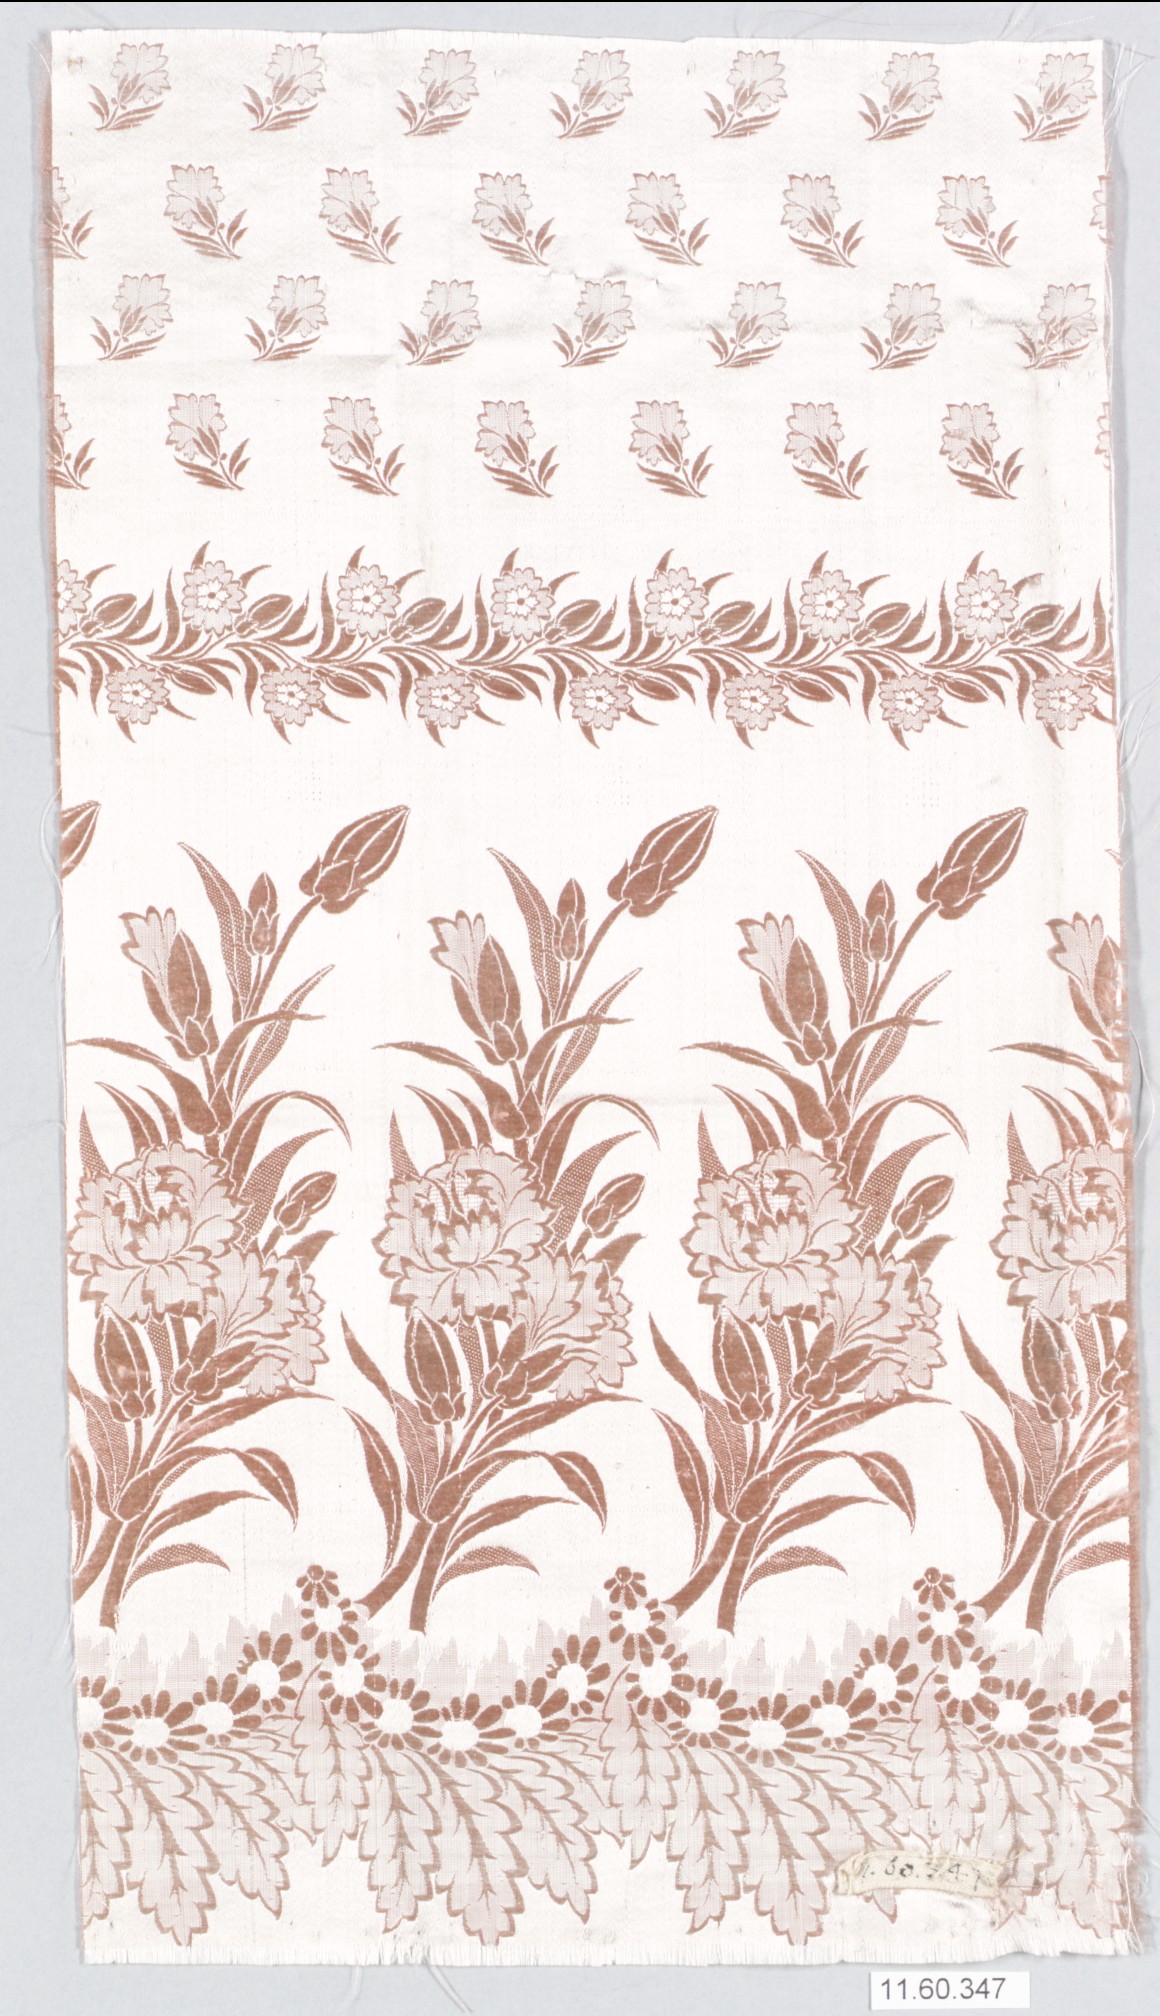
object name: fragment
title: Fragments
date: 1801-1900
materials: silk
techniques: weave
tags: flowers,leaves